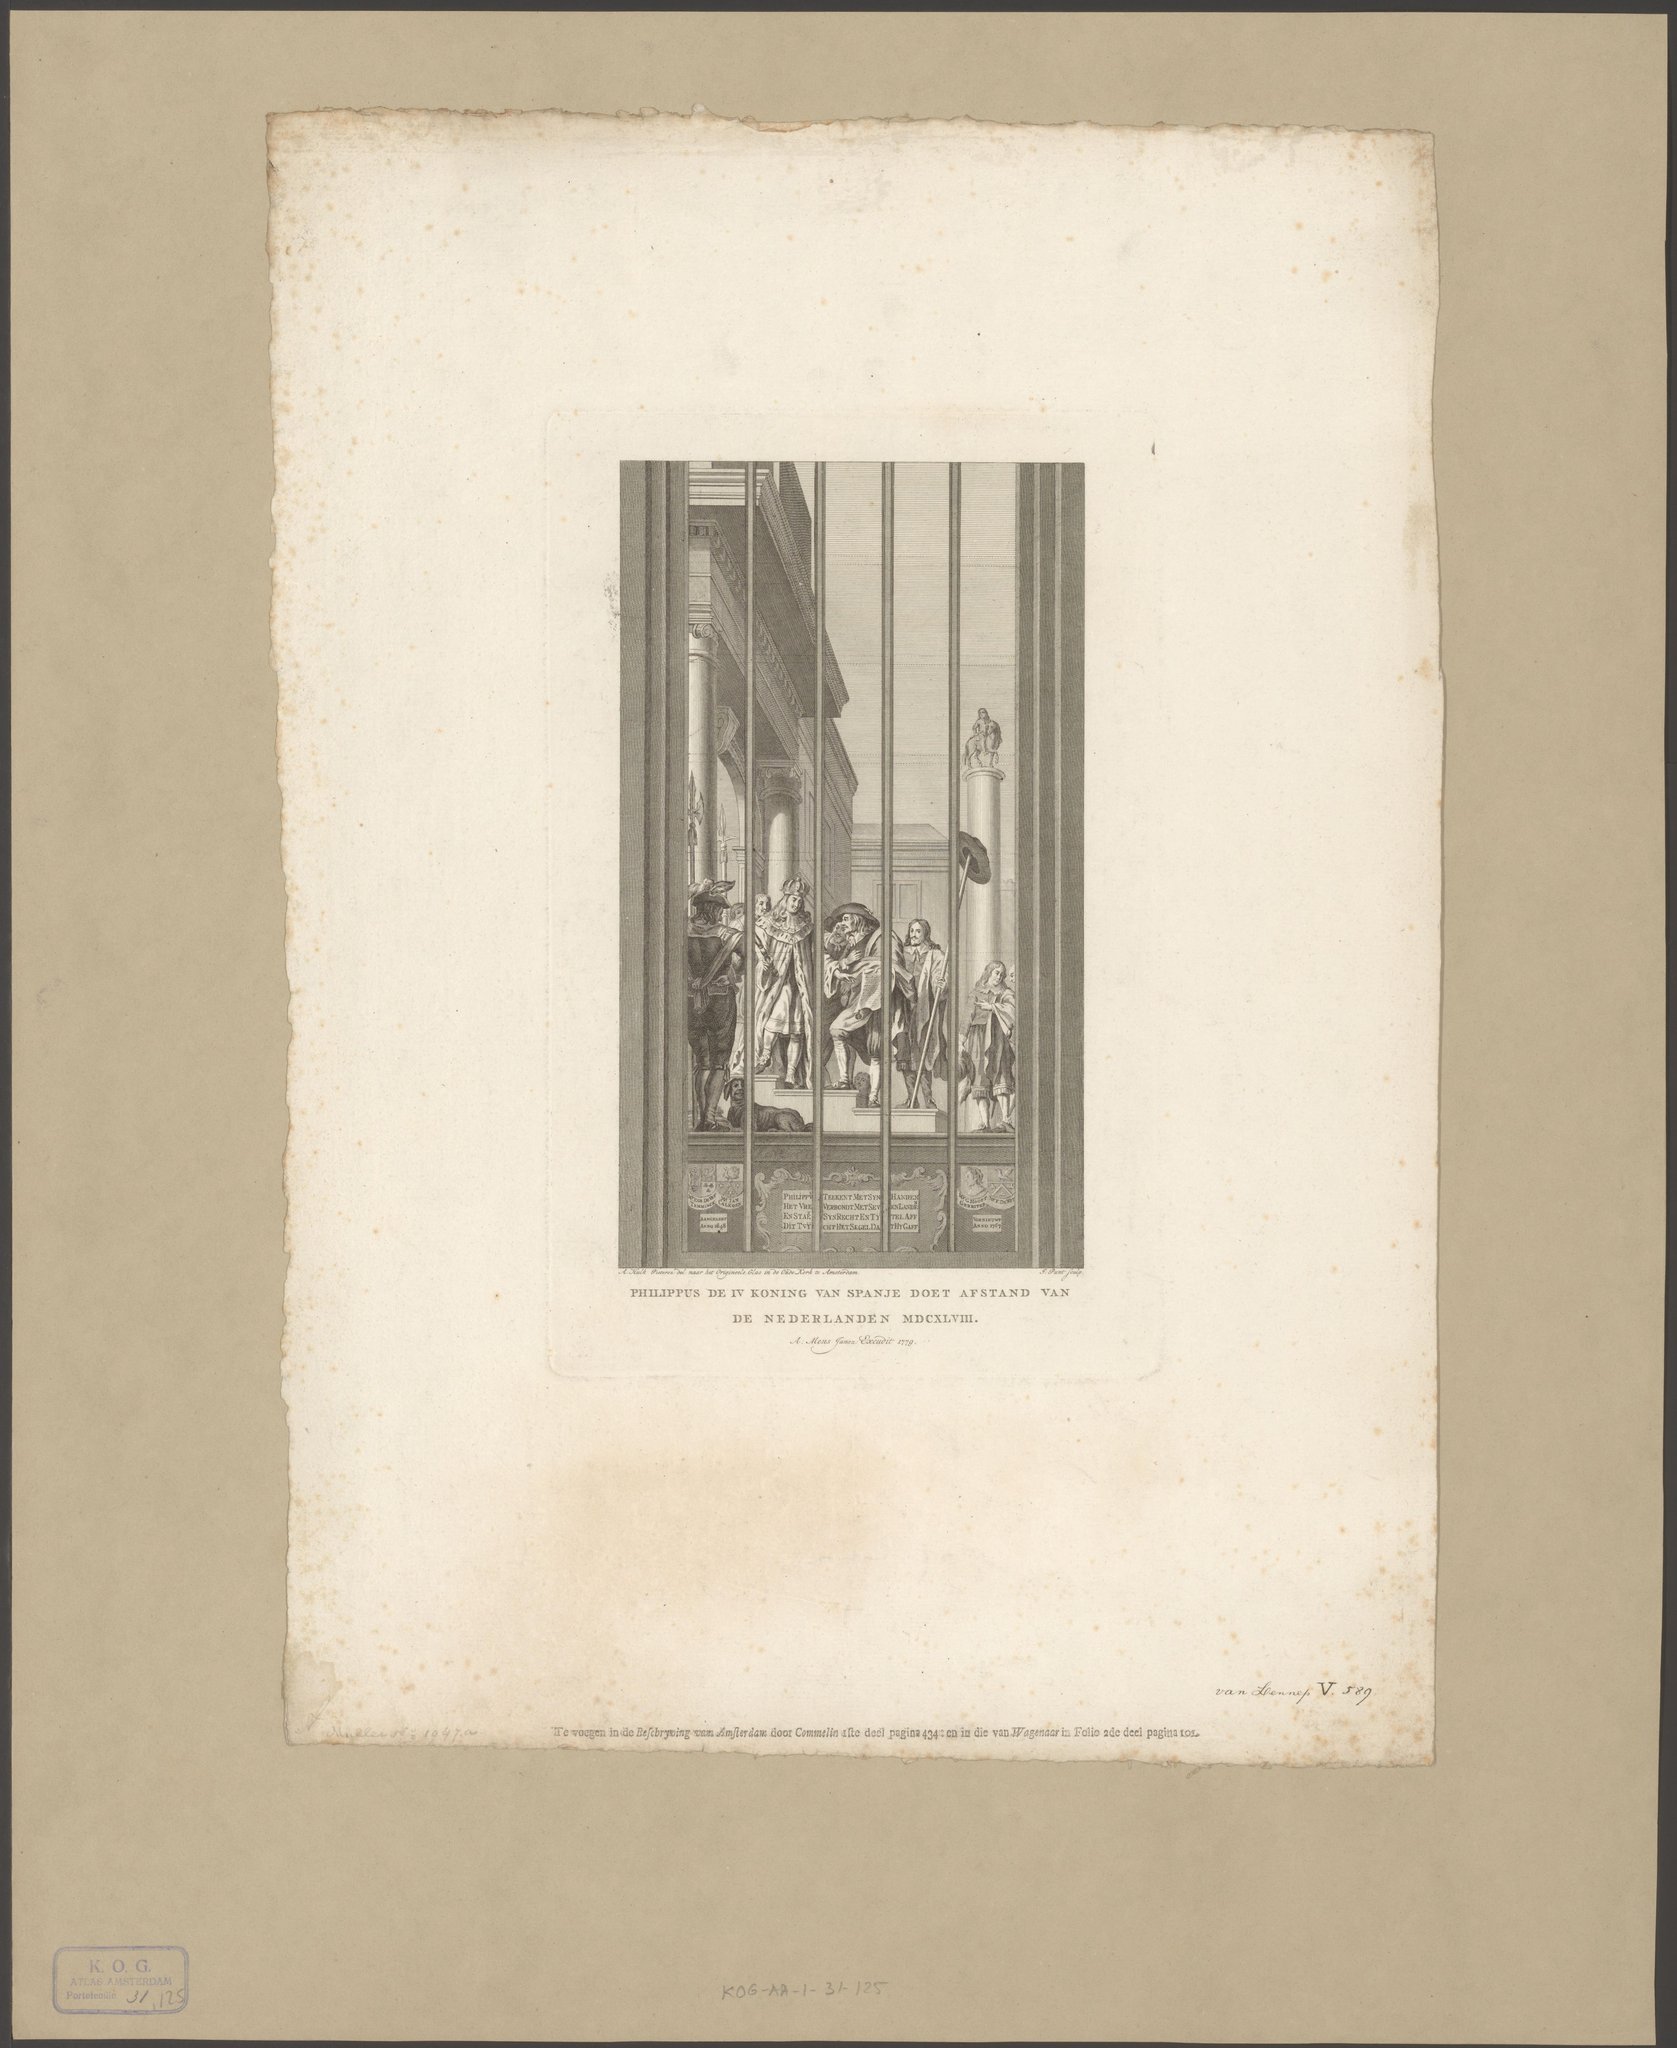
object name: print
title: Philippus de IV Koning van Spanje doet afstand van de Nederlanden MDCXLVIII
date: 1779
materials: paper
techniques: engraving, etching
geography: amsterdam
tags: filips iv (koning van spanje), church-window, e.g. rose-window, signing of peace treaty, concluding the peace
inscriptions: inscription: ‘van Lennep V. 589’, collector's mark: ‘31.125’ Lugt 1641b, inscription: ‘Te voegen in de Beschryving van Amsterdam door Commelin Iste deel pagina 434: en in die van Wagenaar in Folio 2de deel pagina 101.’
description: Volgens de instructies onderaan het blad kon de prent als illustratie ingevoegd worden in de Beschryving van Amsterdam door Commelin, dl. 1, p. 434, of in Wagenaar, Amsterdam, in zyne opkomst etc., dl. 2, p. 101. Staat met de letter.